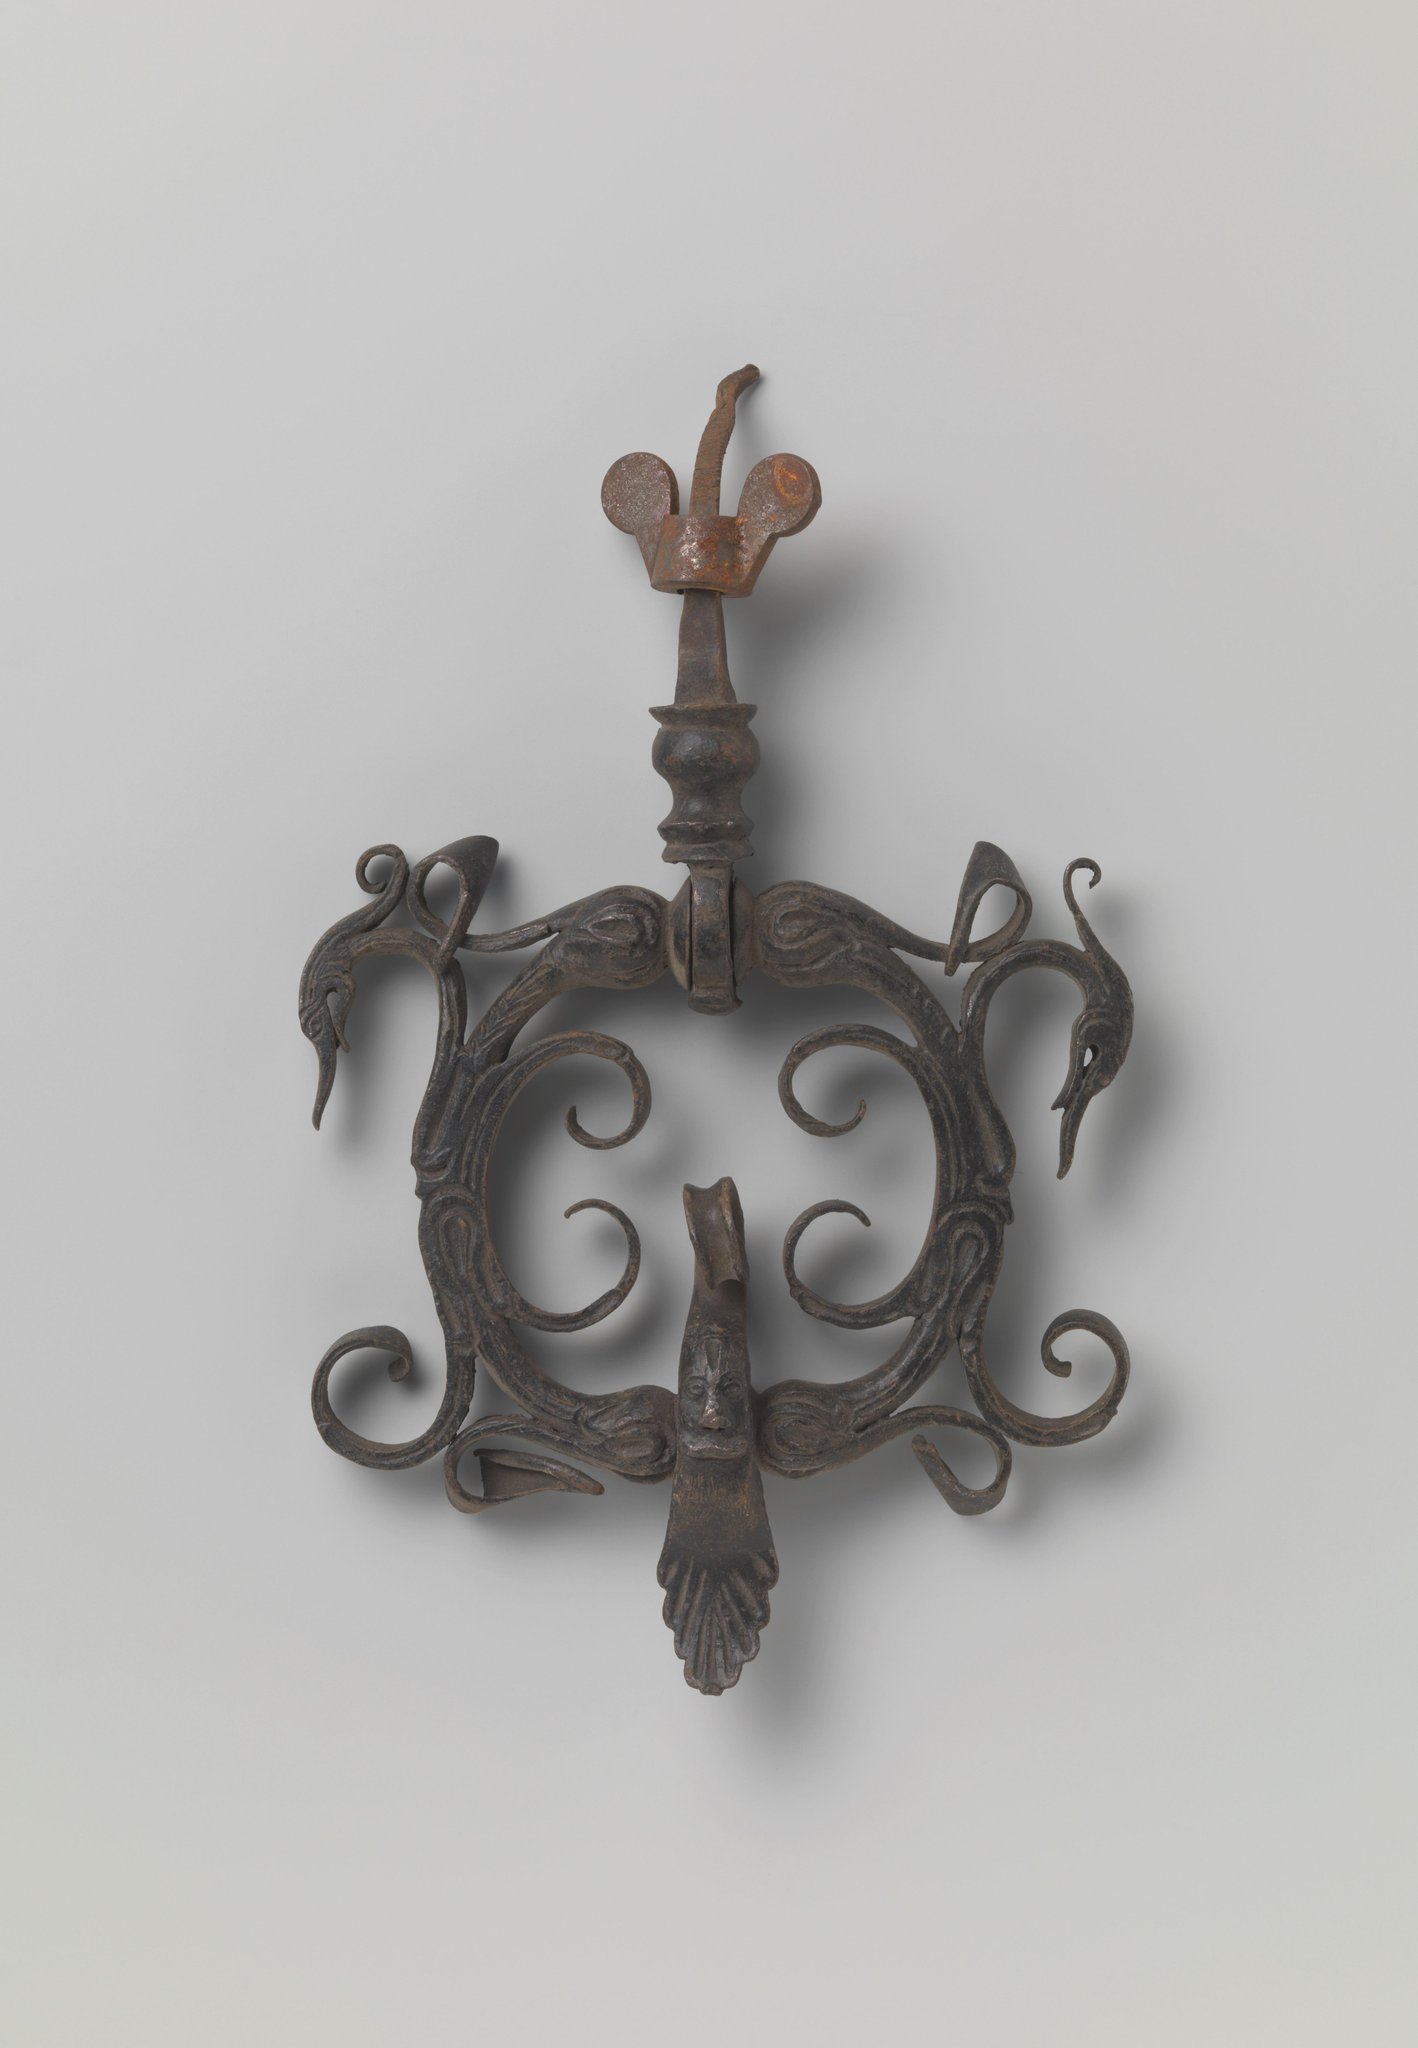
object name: door knocker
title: Deurklopper.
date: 1400-1500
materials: iron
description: Een ijzeren deurklopper met plaat. Afkomstig uit de verzameling D. van der Kellen.